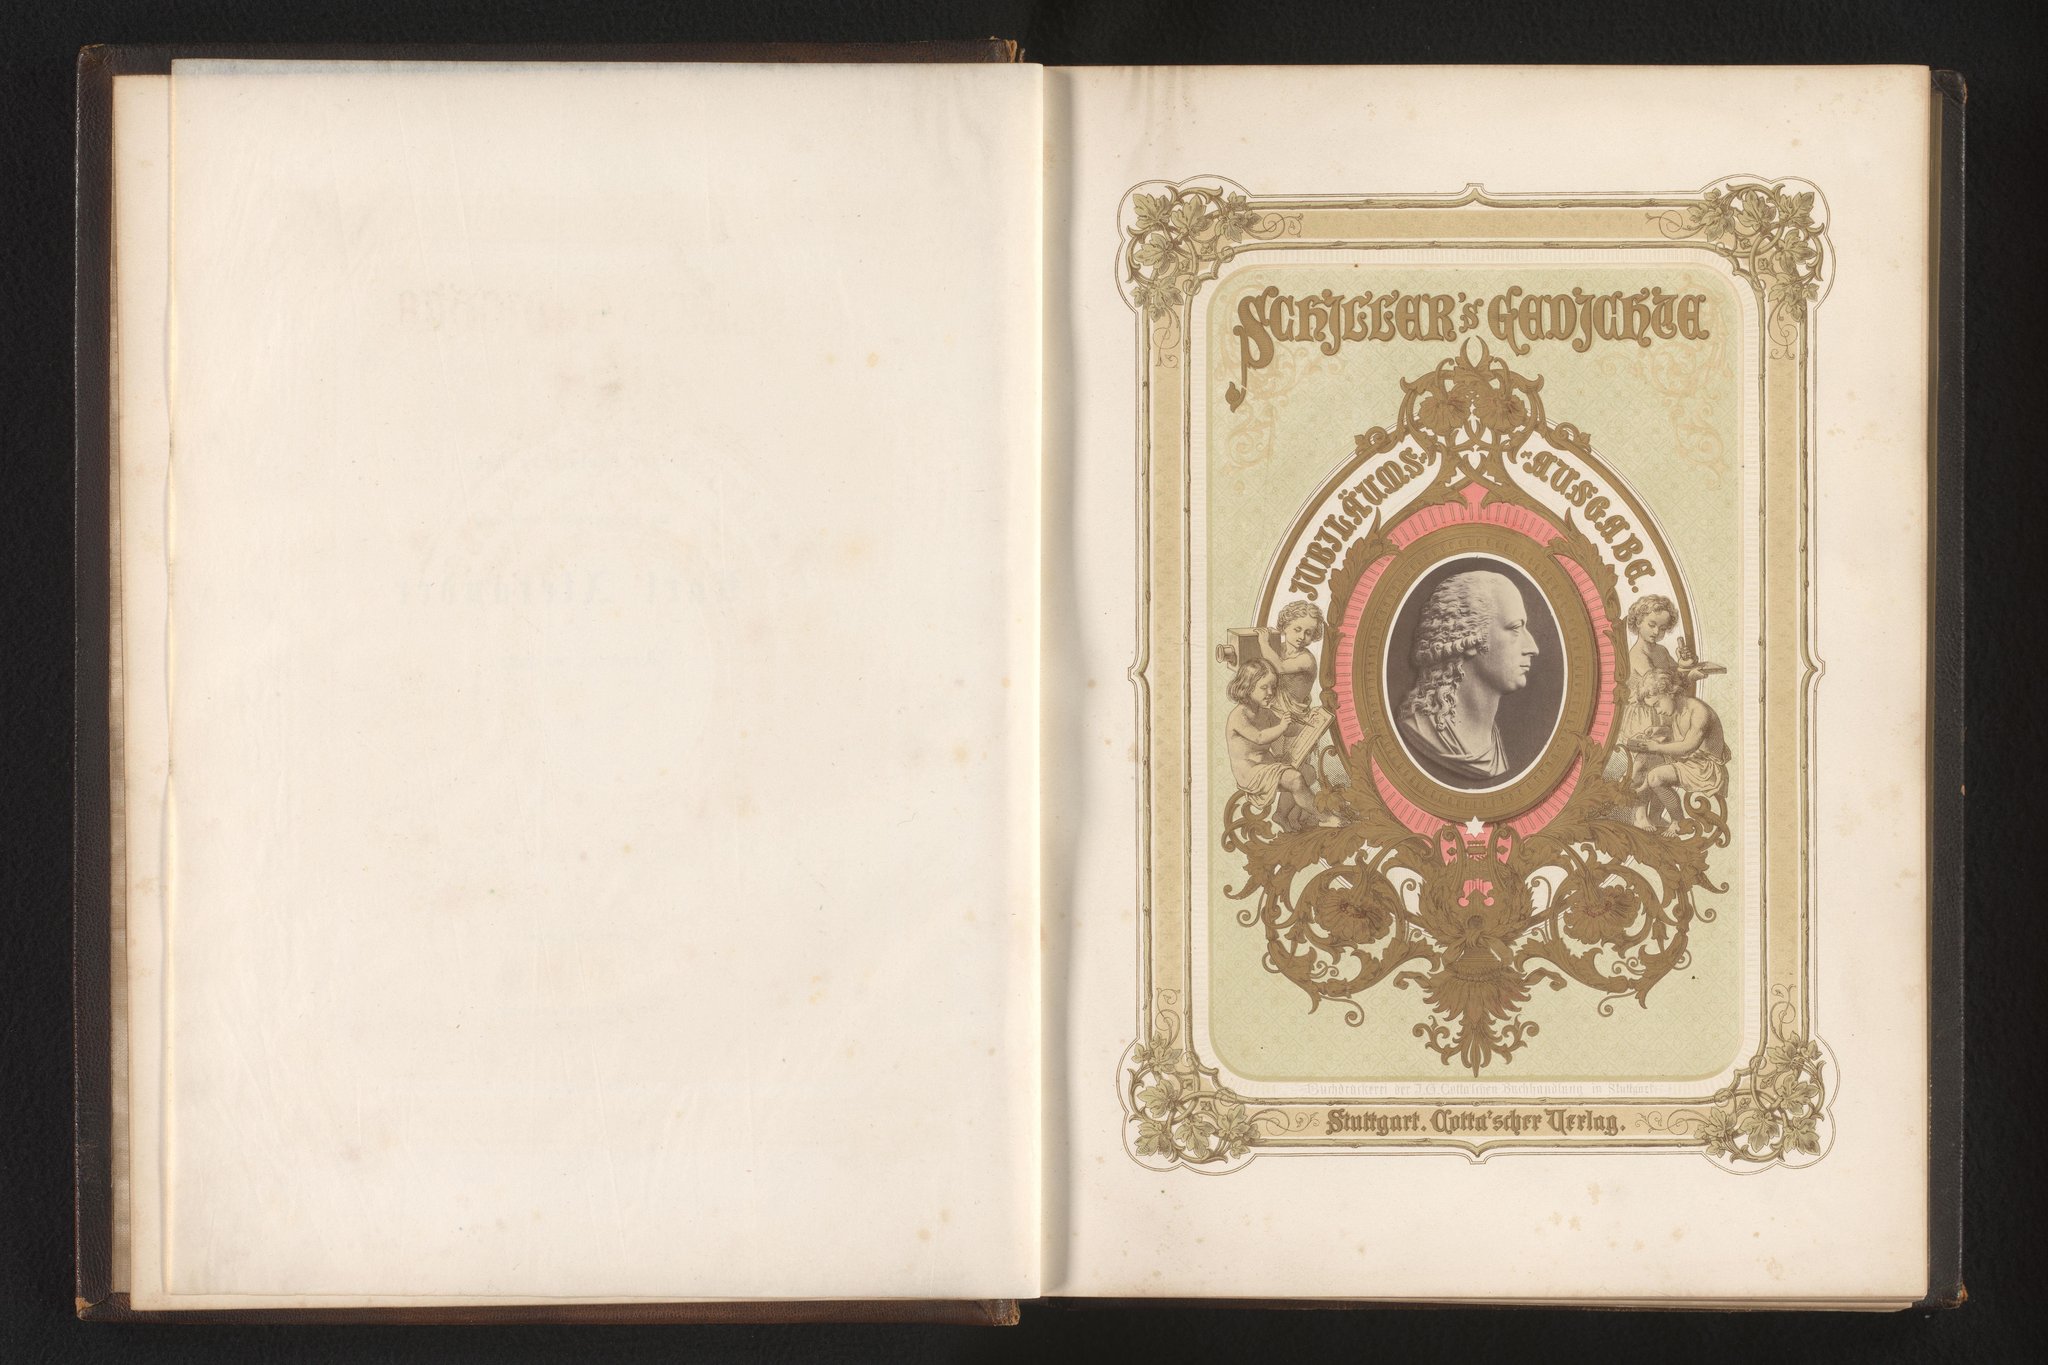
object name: reproduction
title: Fotoreproductie van een basreliëf met een portret van Schiller door Scheffauer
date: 1855-1862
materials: paper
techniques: albumen print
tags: friedrich von schiller, historical persons, portrait of a writer, piece of sculpture, reproduction of a piece of sculpture